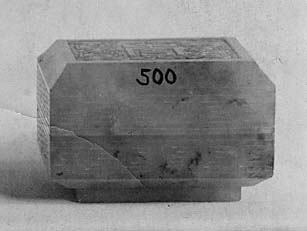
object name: covered box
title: Covered Box from an Altar Set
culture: chinese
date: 1736-1795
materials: gemstone, jade, wood